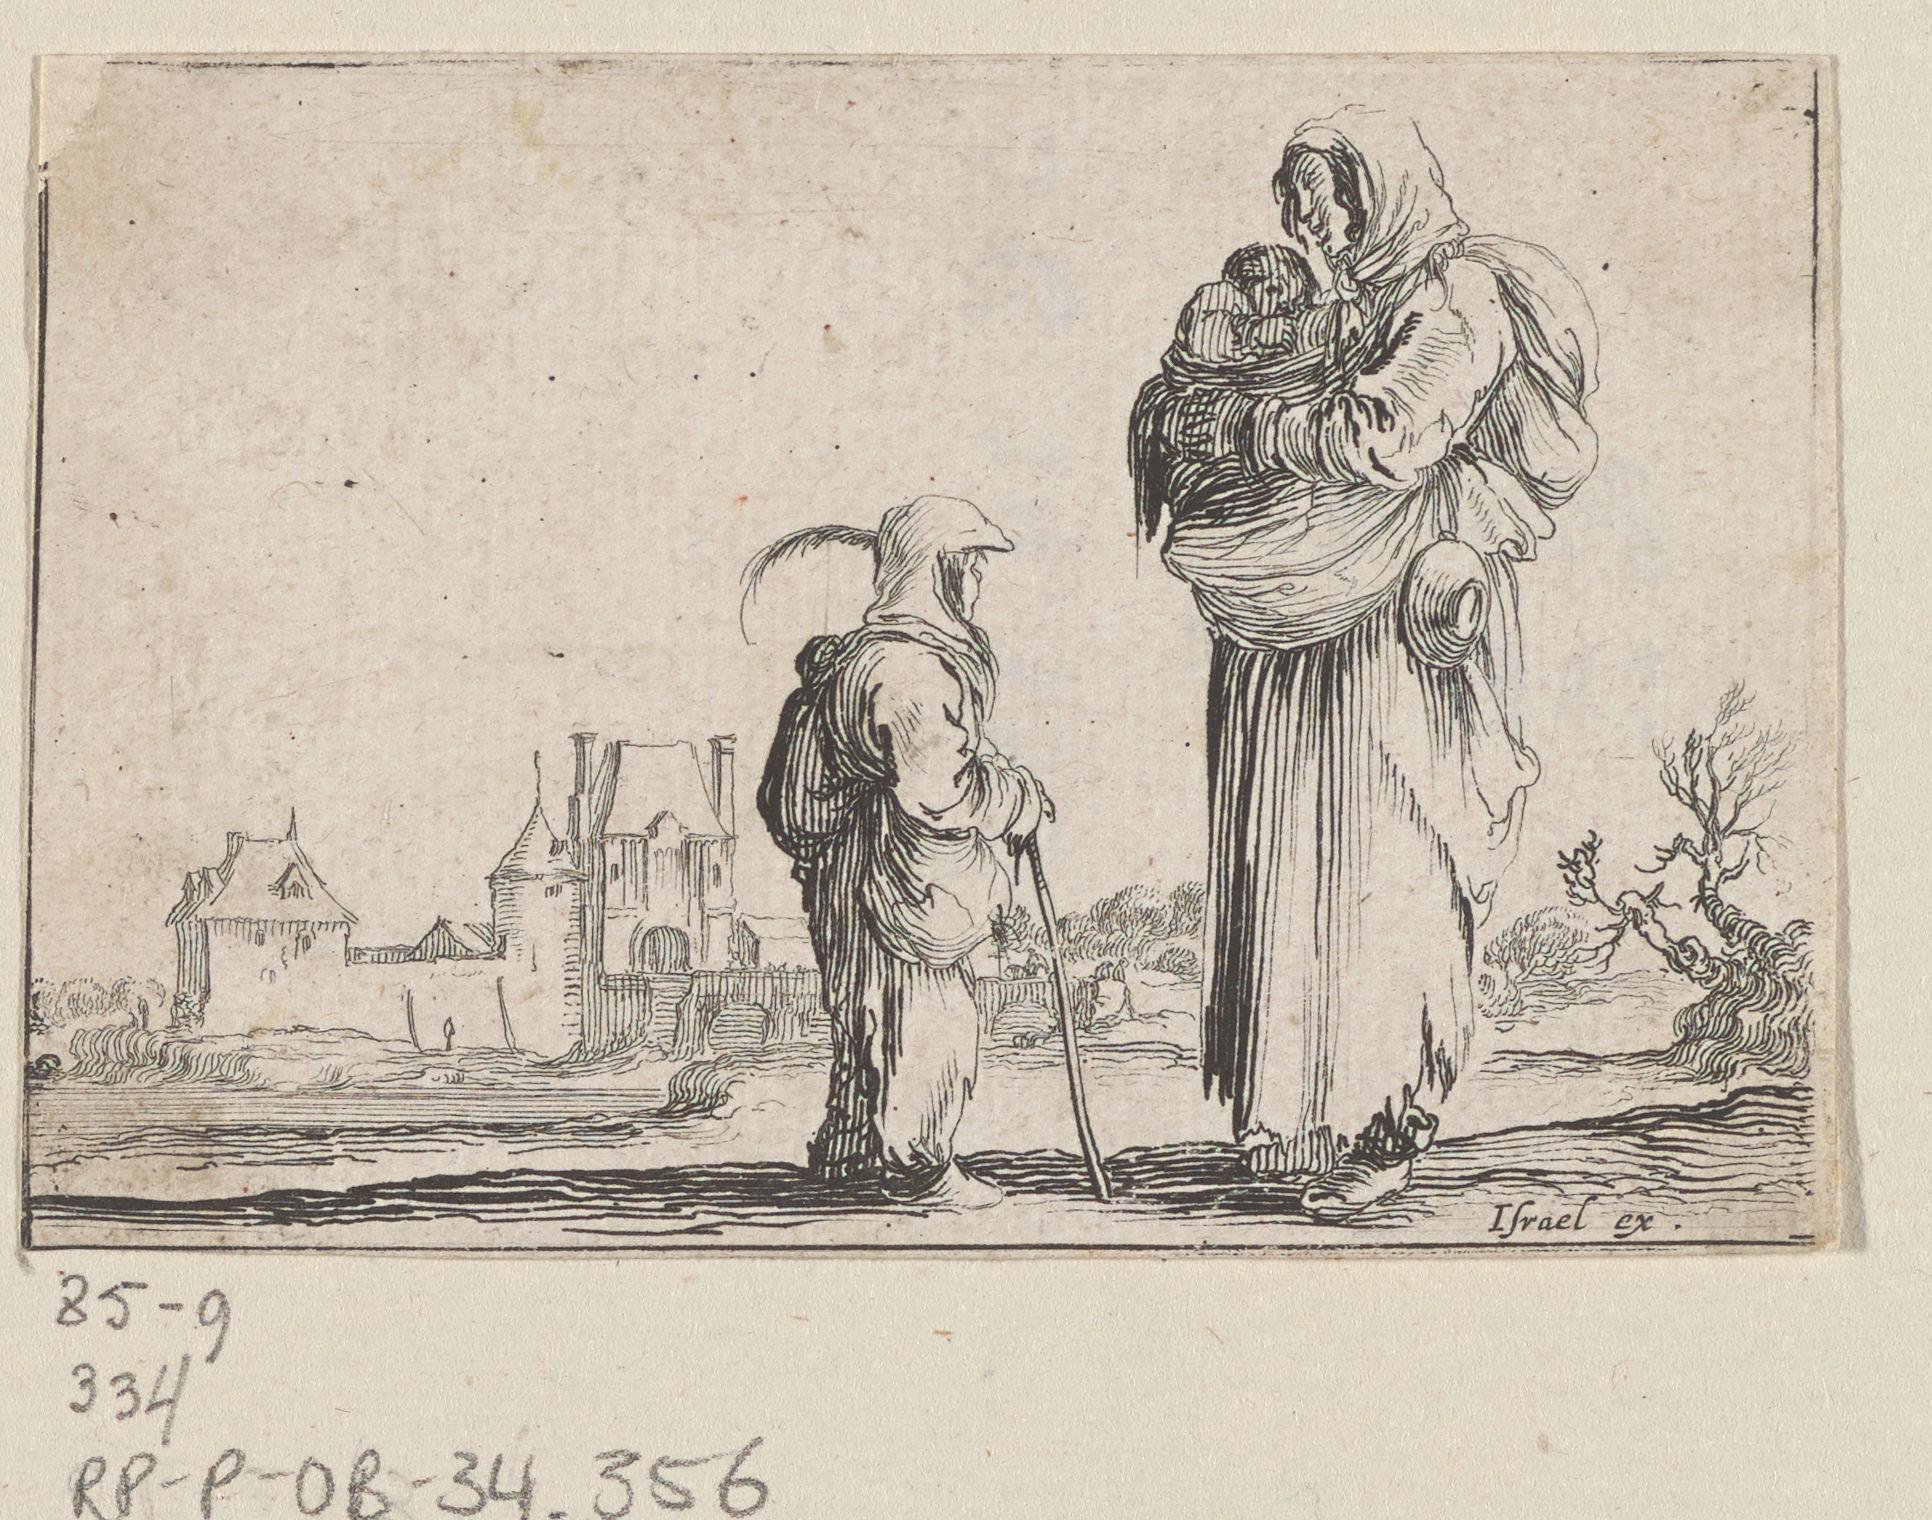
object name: print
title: Vrouw met kind op de arm en een staand kind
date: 1620-1664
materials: paper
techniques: etching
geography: france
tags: mother and child(ren), woman and child(ren) (family group)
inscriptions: collector's mark: Lugt 240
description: Prent uit een reeks van 13 prenten inclusief titelprent.